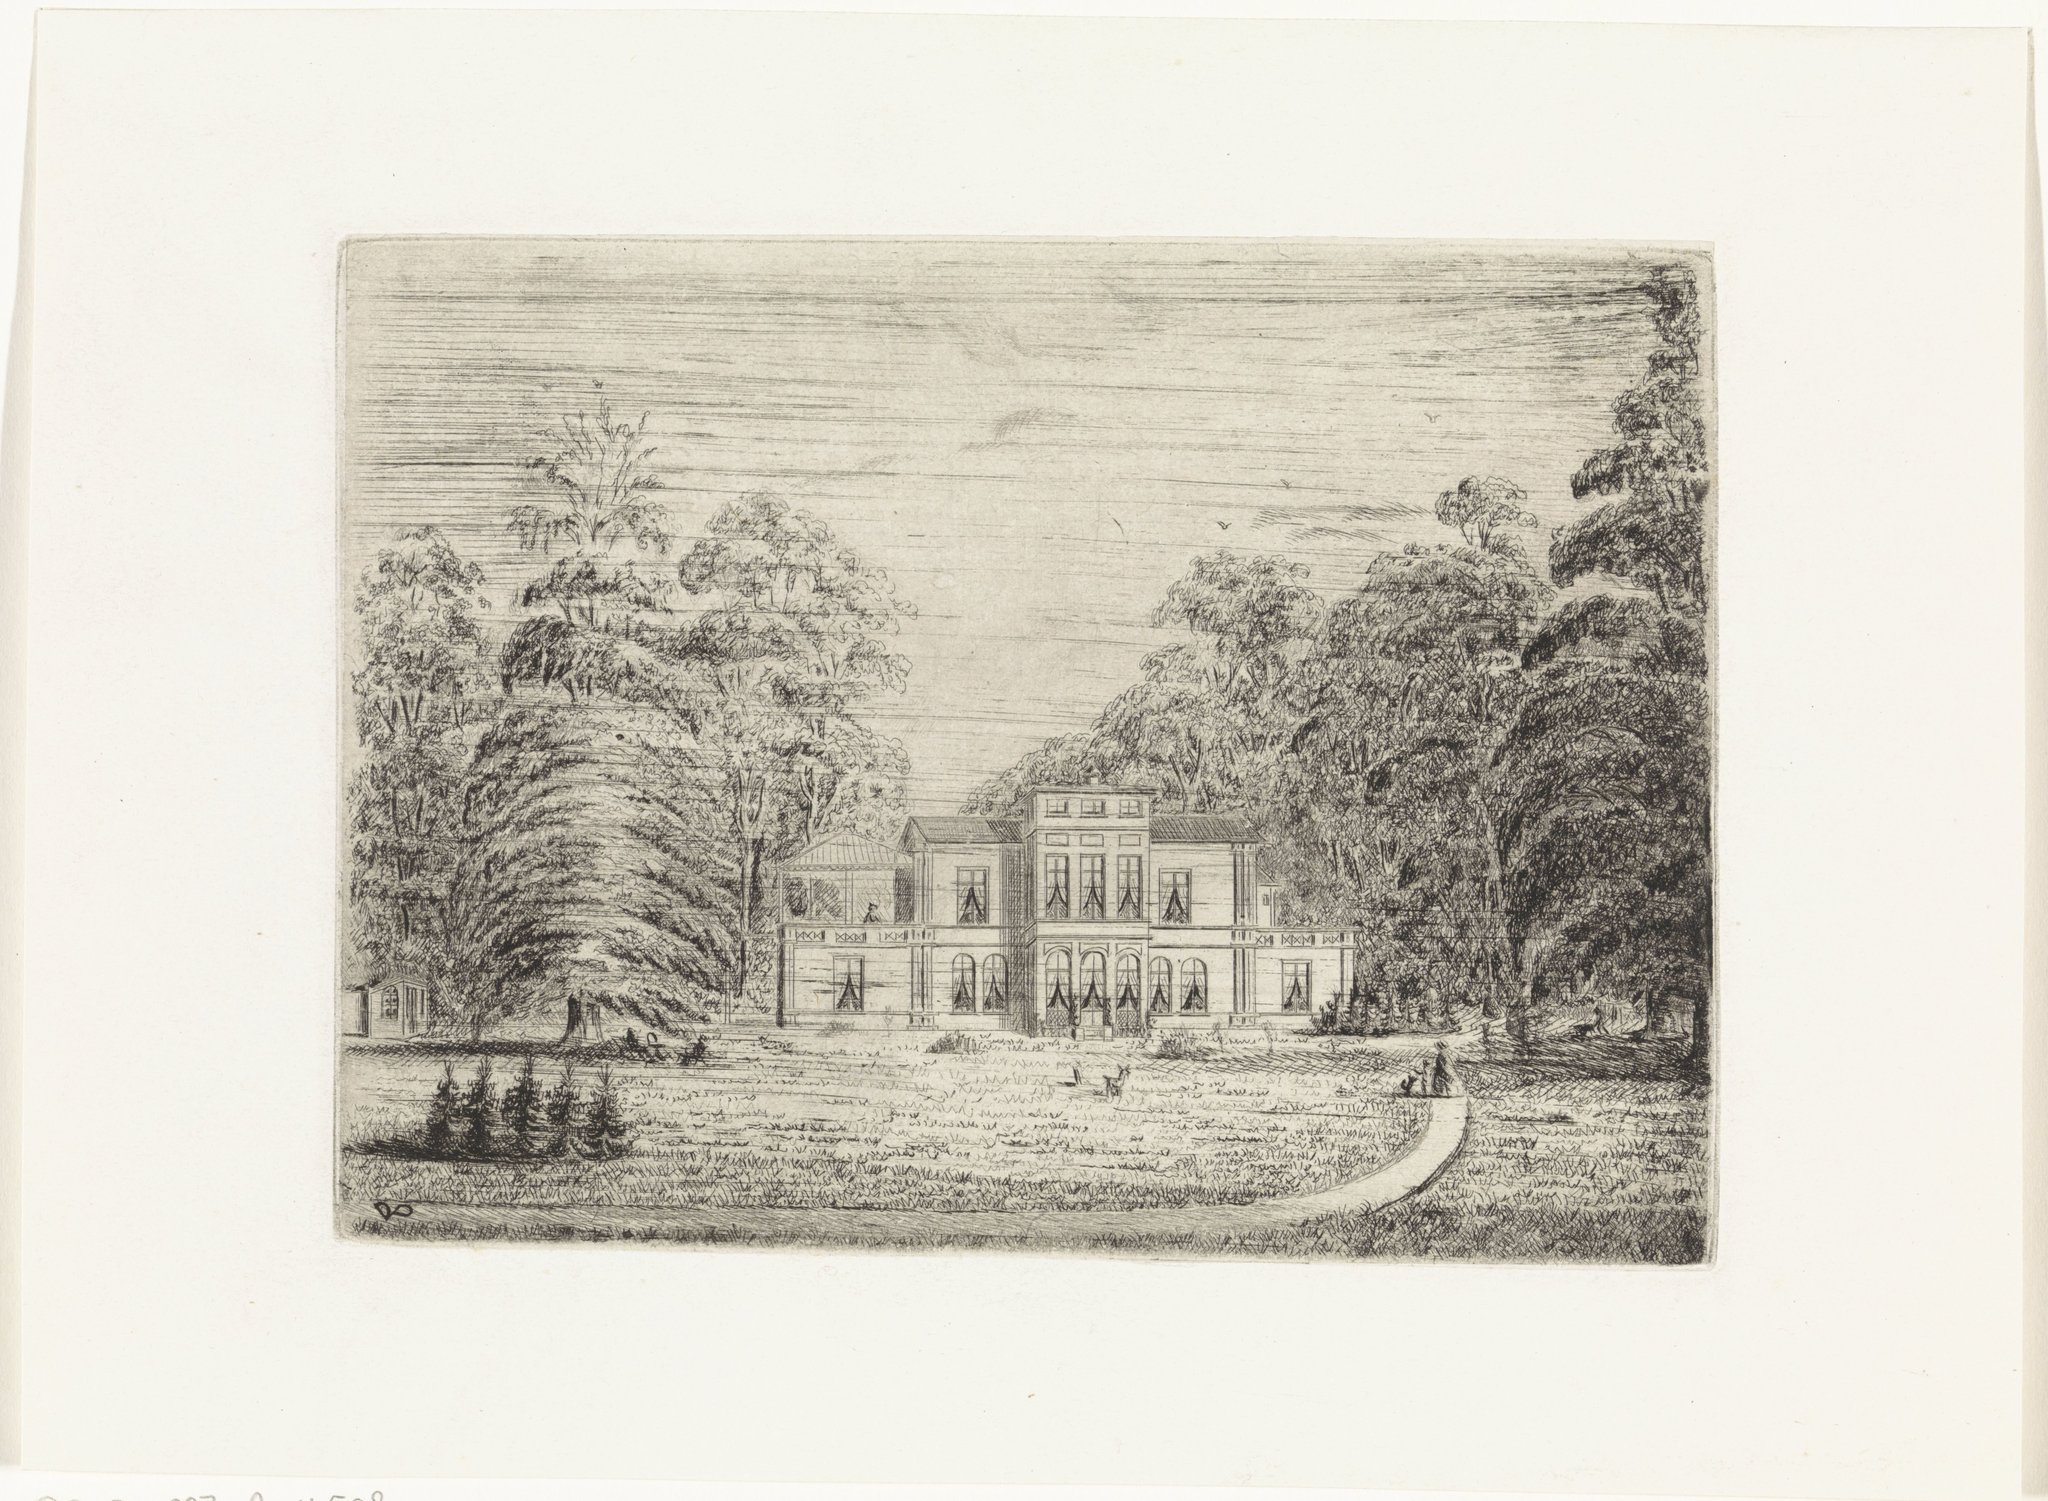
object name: print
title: Gezicht op een buitenplaats te Baarn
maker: pieter cornelis nicolaas van de poll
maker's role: print maker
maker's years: 1825-1892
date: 1835-1887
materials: paper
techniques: etching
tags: rural housing, e.g. country-house, villa, cottage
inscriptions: inscription: ‘Buitenplaats te Baarn. P. van der Poll’, collector's mark: Lugt 2228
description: Gezicht op een buitenplaats te Baarn met monumentale bomen. Op een pad een vrouw met een kind en een hond. Onder een boom zitten twee mannen op stoelen bij een theehuisje.